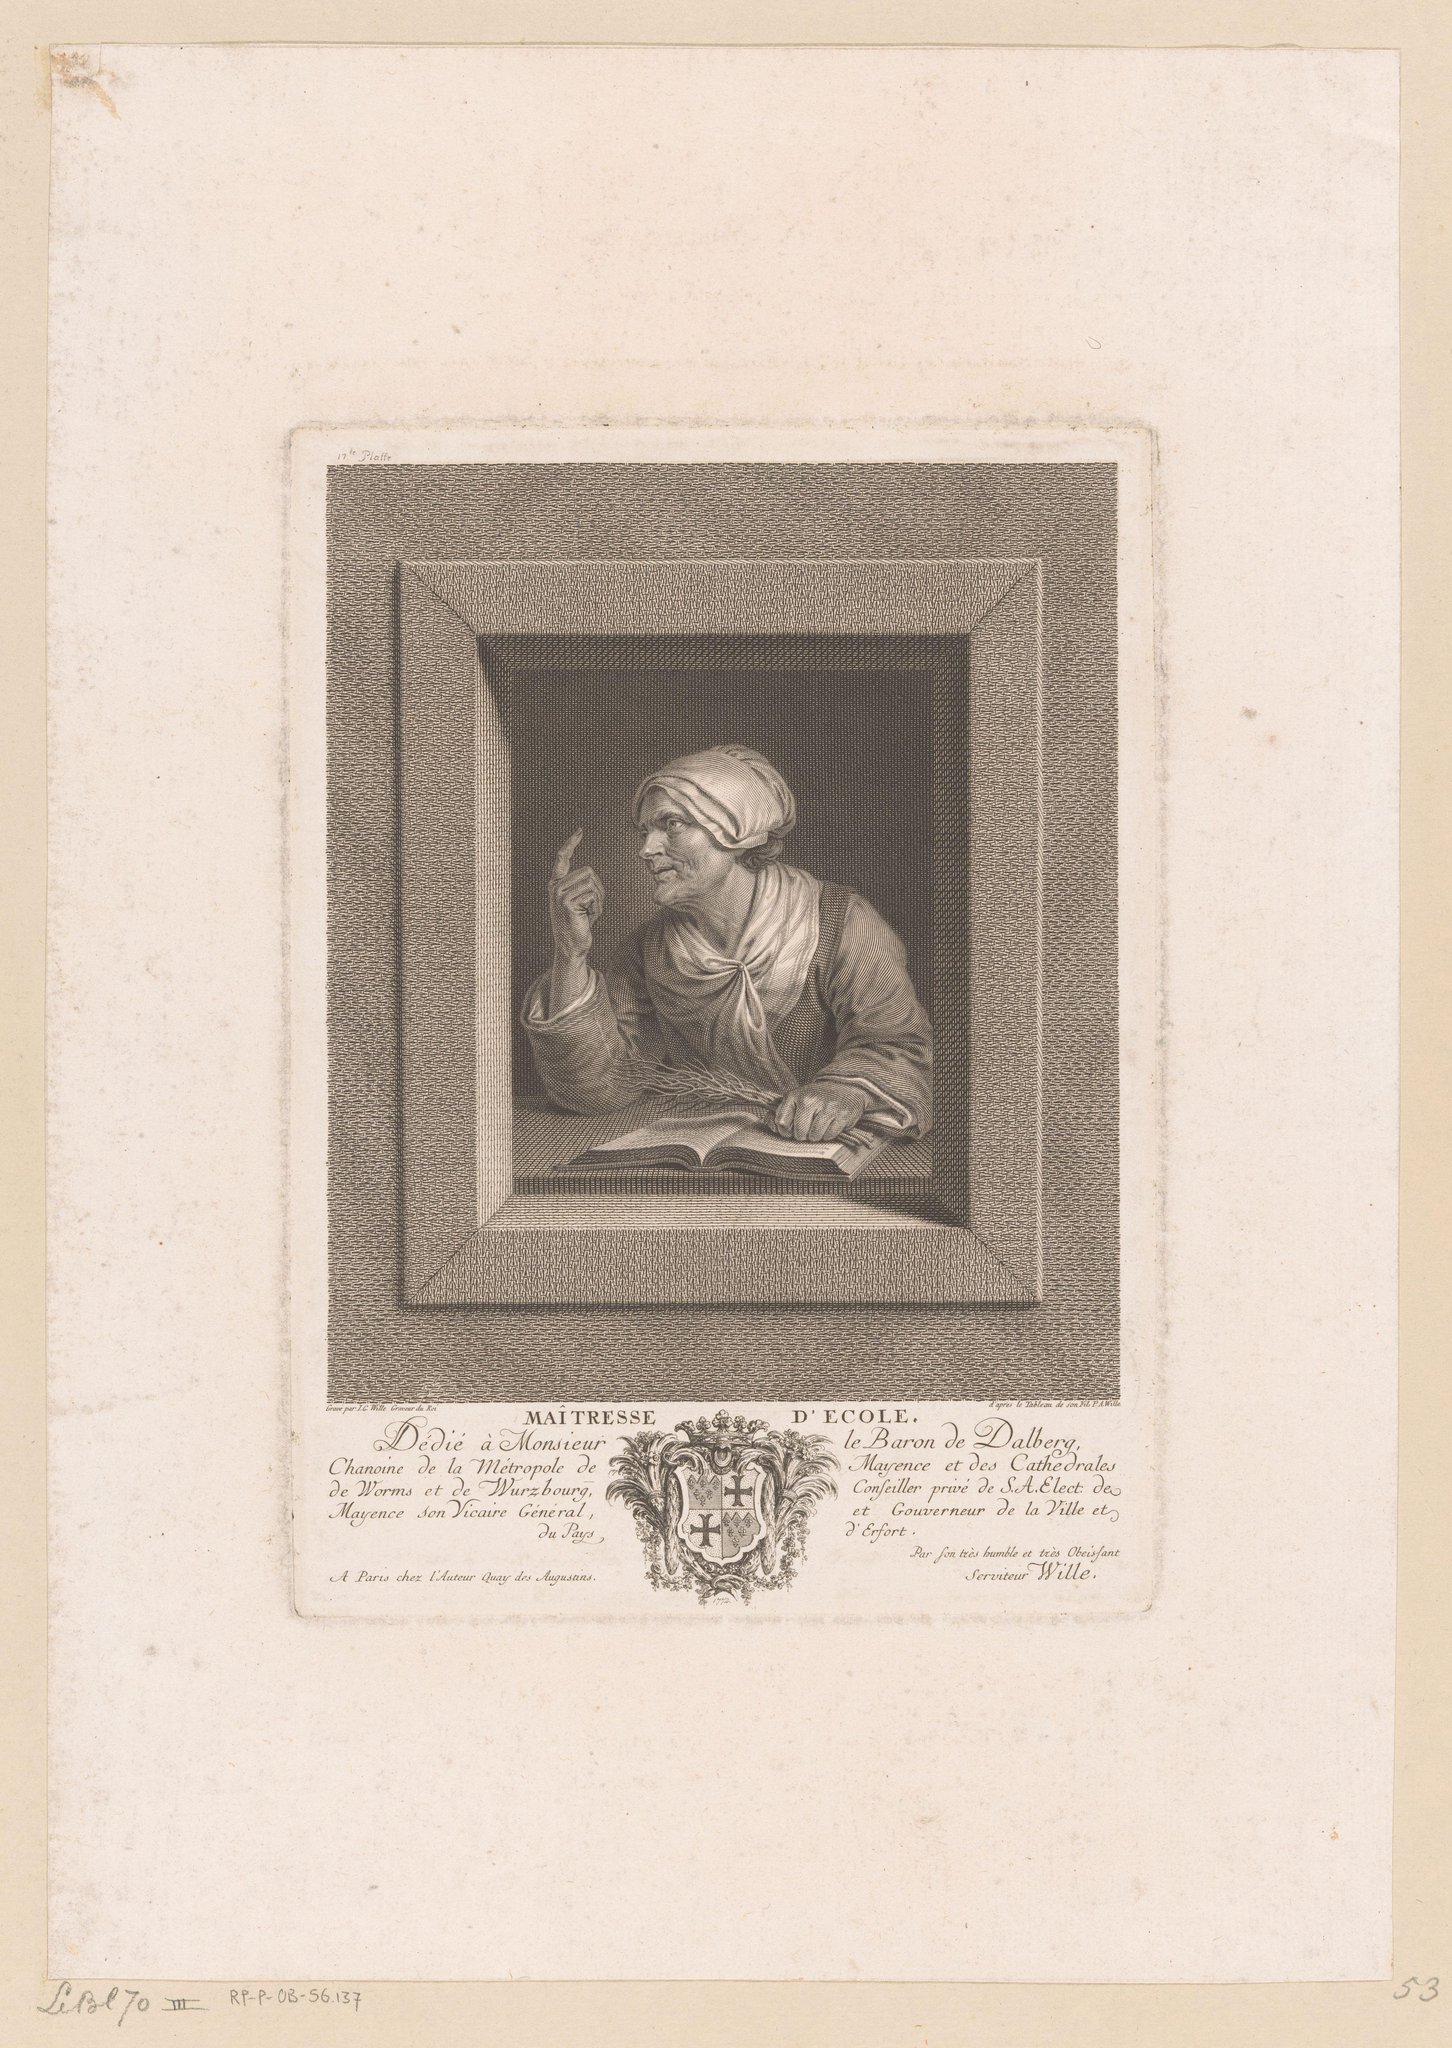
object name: print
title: Maîtresse d'ecole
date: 1772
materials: paper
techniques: engraving, etching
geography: paris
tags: old woman, rod, birch ~ punishment at school, index finger forwards, pointing, indicating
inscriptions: collector's mark: Lugt 240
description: Deze prent maakt deel uit van een serie van onbekende omvang naar Nederlandse en Duitse schilderijen. Op sommige prenten staat linksboven aangegeven welk nummer in de serie het betreft.